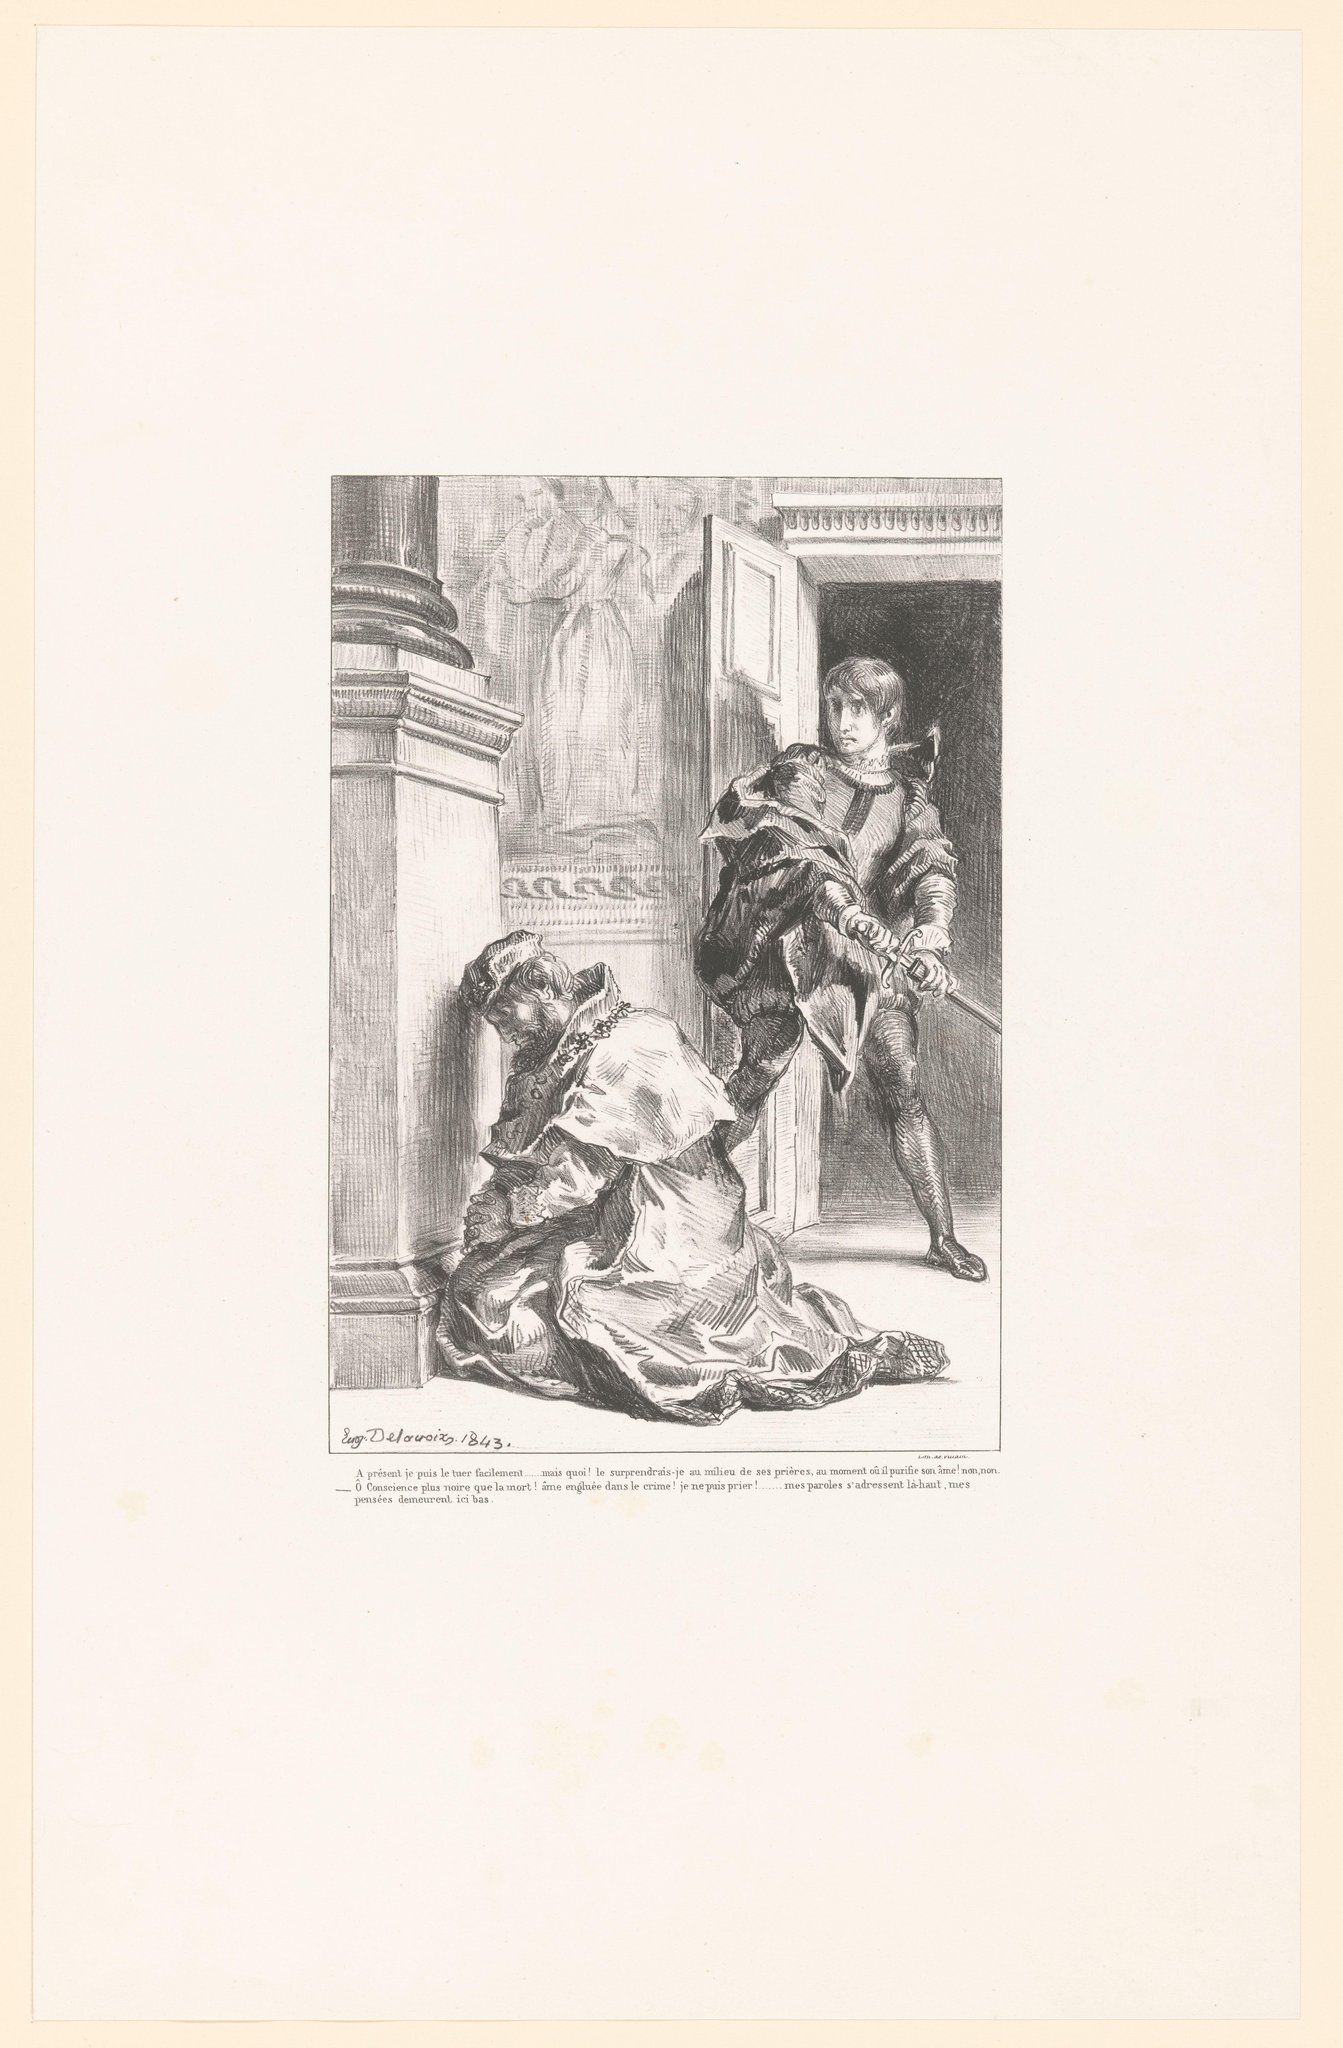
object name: print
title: Hamlet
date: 1843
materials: paper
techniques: lithograph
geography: paris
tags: hamlet, prince of denmark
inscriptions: collector's mark: Lugt 2760, collector's mark: Lugt 2228a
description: Prent maakt deel uit van een omslag met veertien prenten.